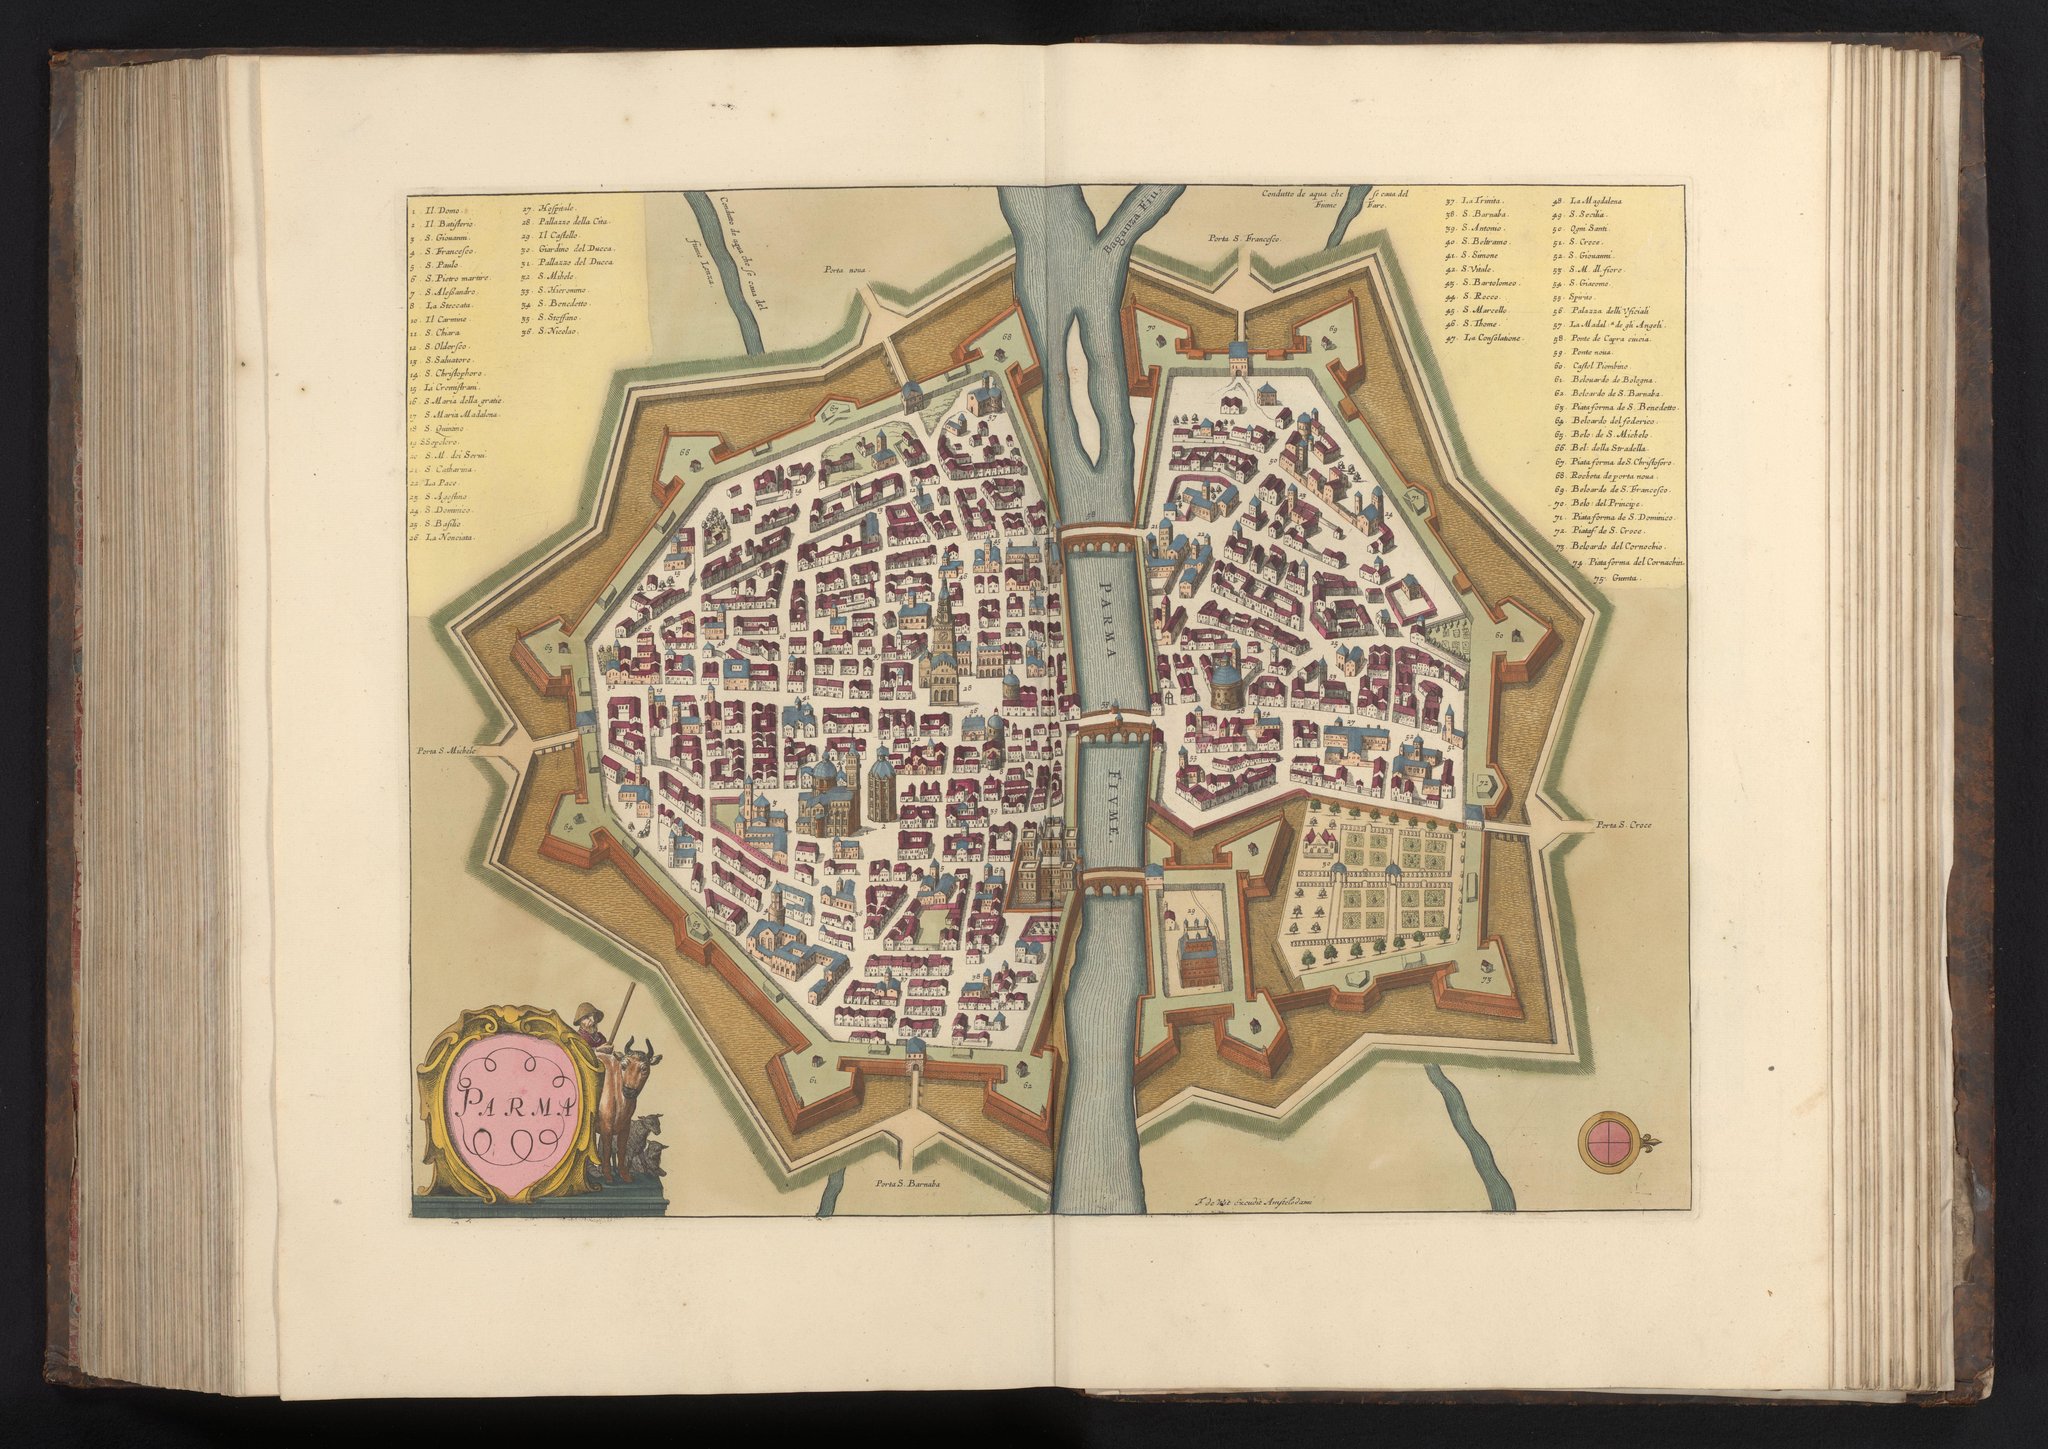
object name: print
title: Parma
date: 1639-1706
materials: paper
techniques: colour, etching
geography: the hague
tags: bird's eye view ~ architectural design or model, maps of cities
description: Gezicht op Parma in vogelvluchtperspectief. Links- en rechtsboven verklarende lijsten met nummers. Linksonder een cartouche met titel. Prent maakt deel uit van een album.